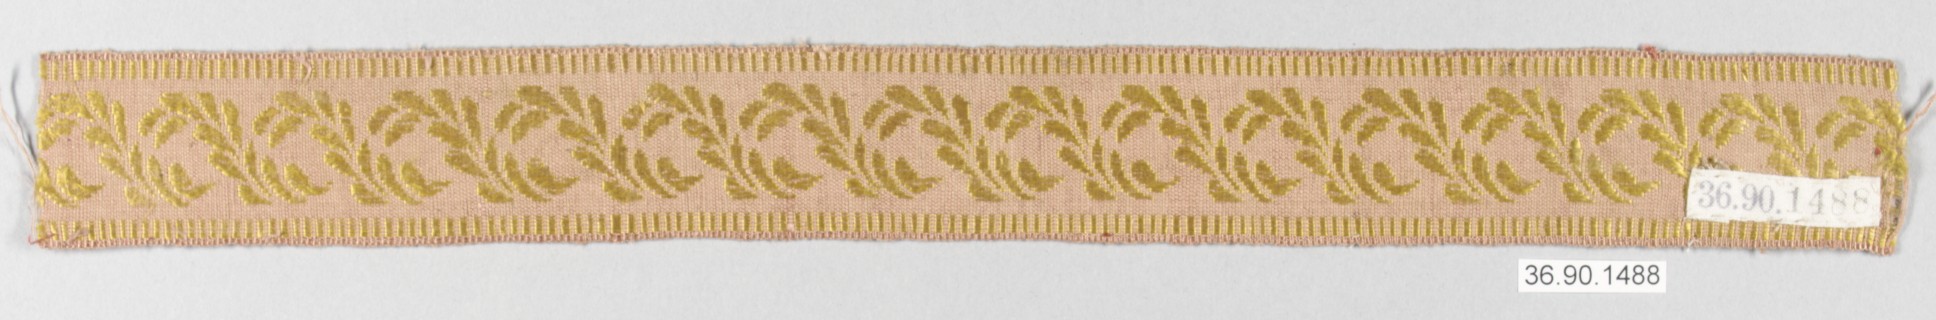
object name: ribbon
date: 1801-1900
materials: silk